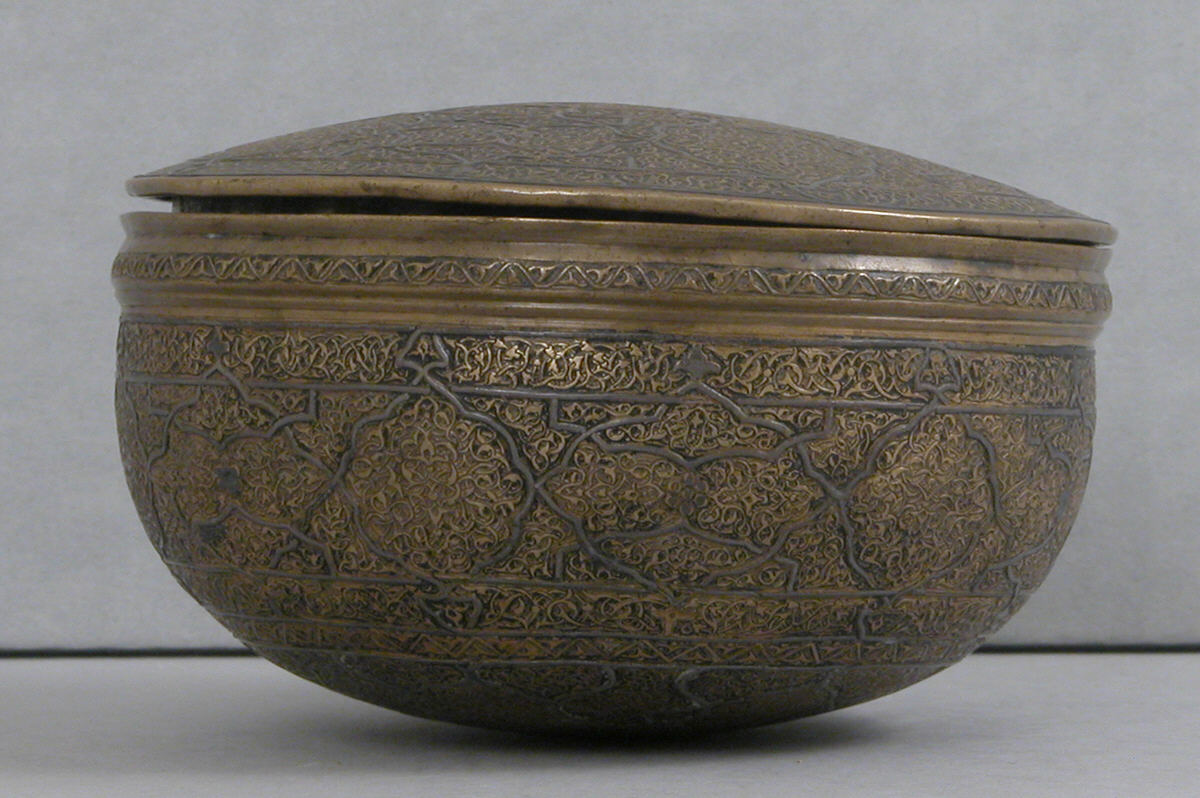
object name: bowl with lid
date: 1401-1500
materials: brass, gold, silver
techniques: inlay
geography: afghanistan